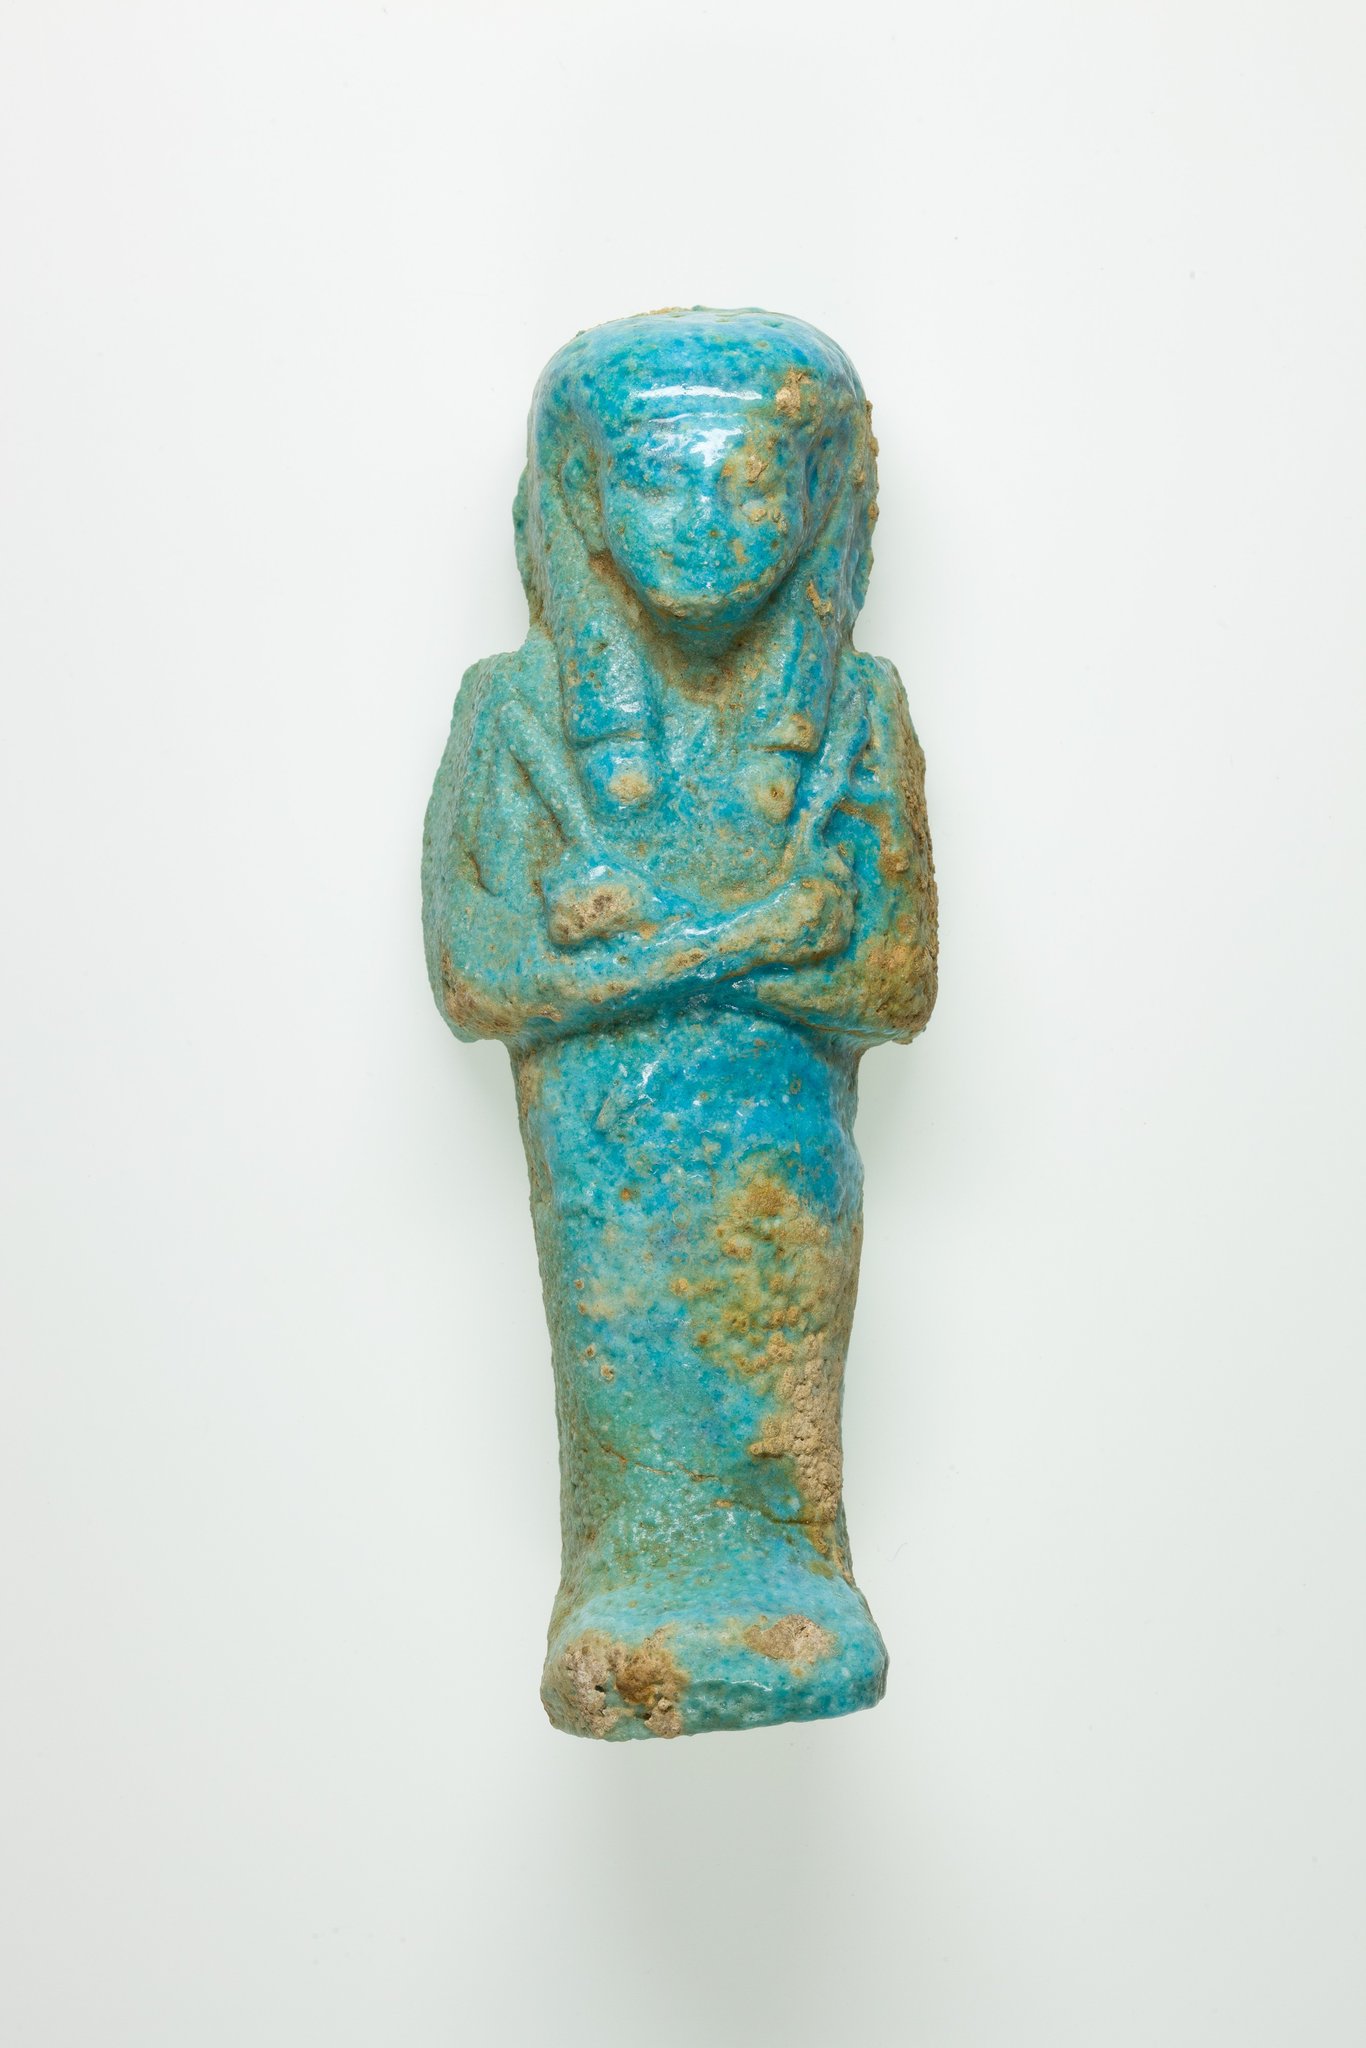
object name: worker shabti, henettawy c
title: Worker Shabti of Henettawy (C), Daughter of Isetemkheb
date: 990-970 BCE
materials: faience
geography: egypt